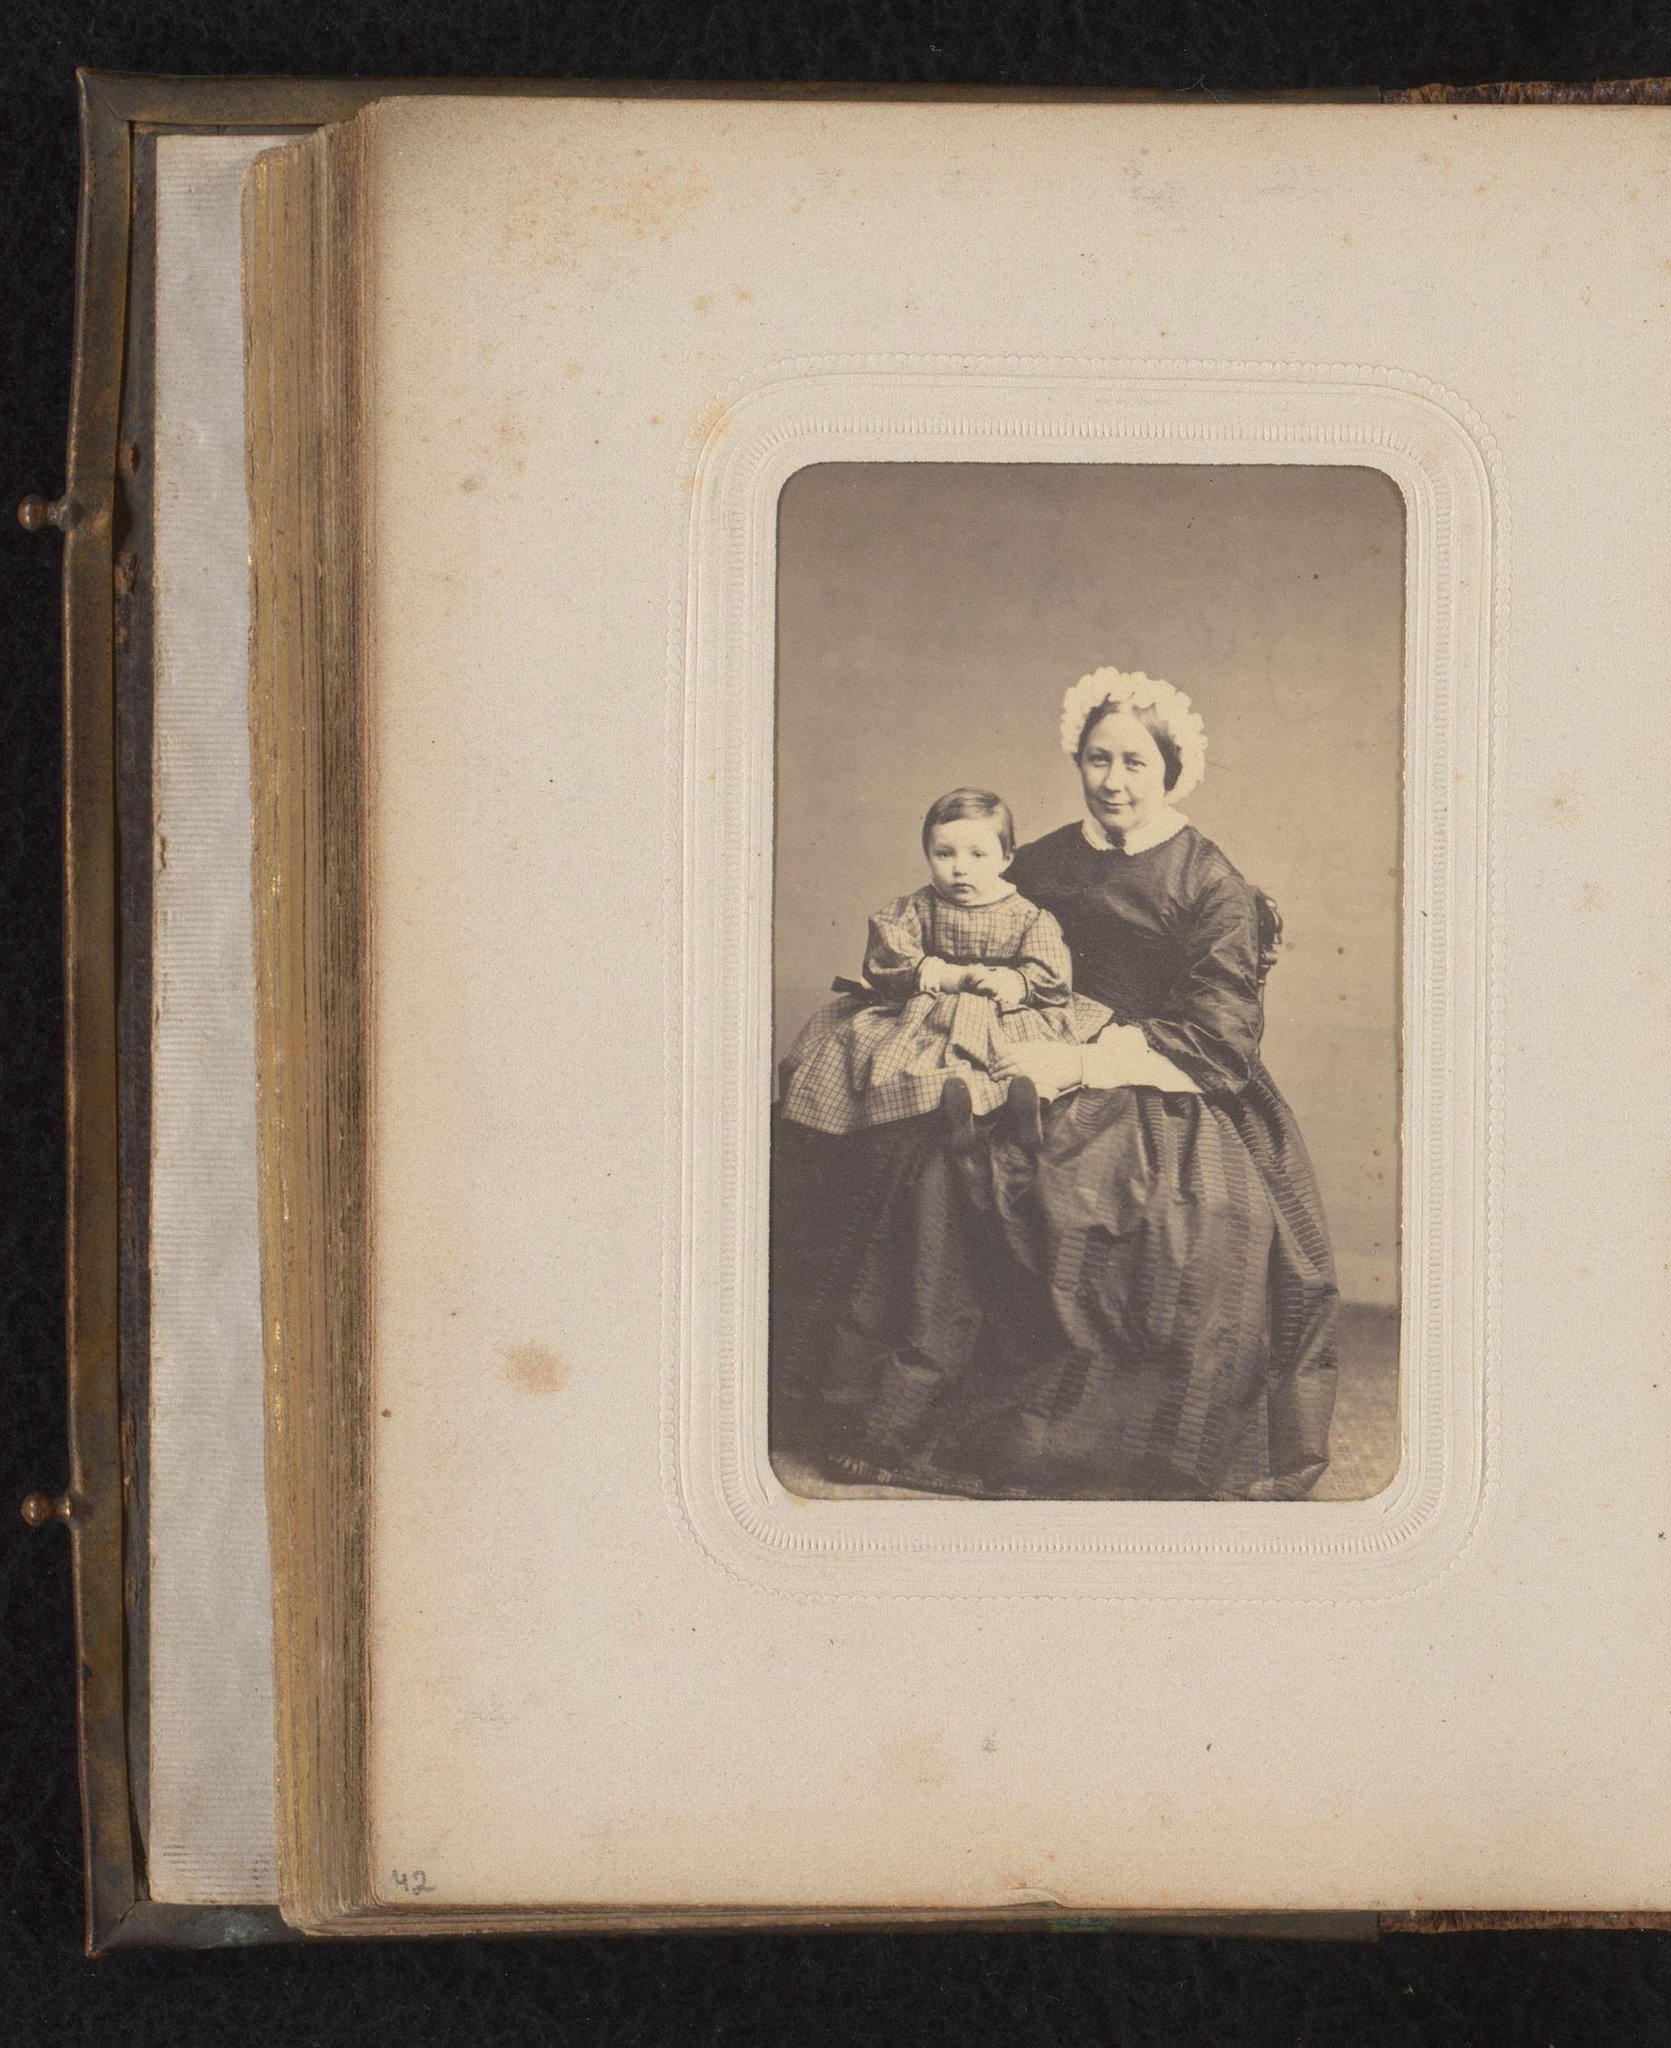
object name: album leaf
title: Portret van een zittende vrouw met een peuter op schoot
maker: l. duchatel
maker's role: fotograaf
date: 1860-1900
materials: cardboard, photographic support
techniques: albumen print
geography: doornik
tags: sitting figure - aa - female human figure, historical persons - bb - woman, tot, toddler ~ the ages of man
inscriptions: inscription: ‘L. DUCHATEL, à Tournai.’